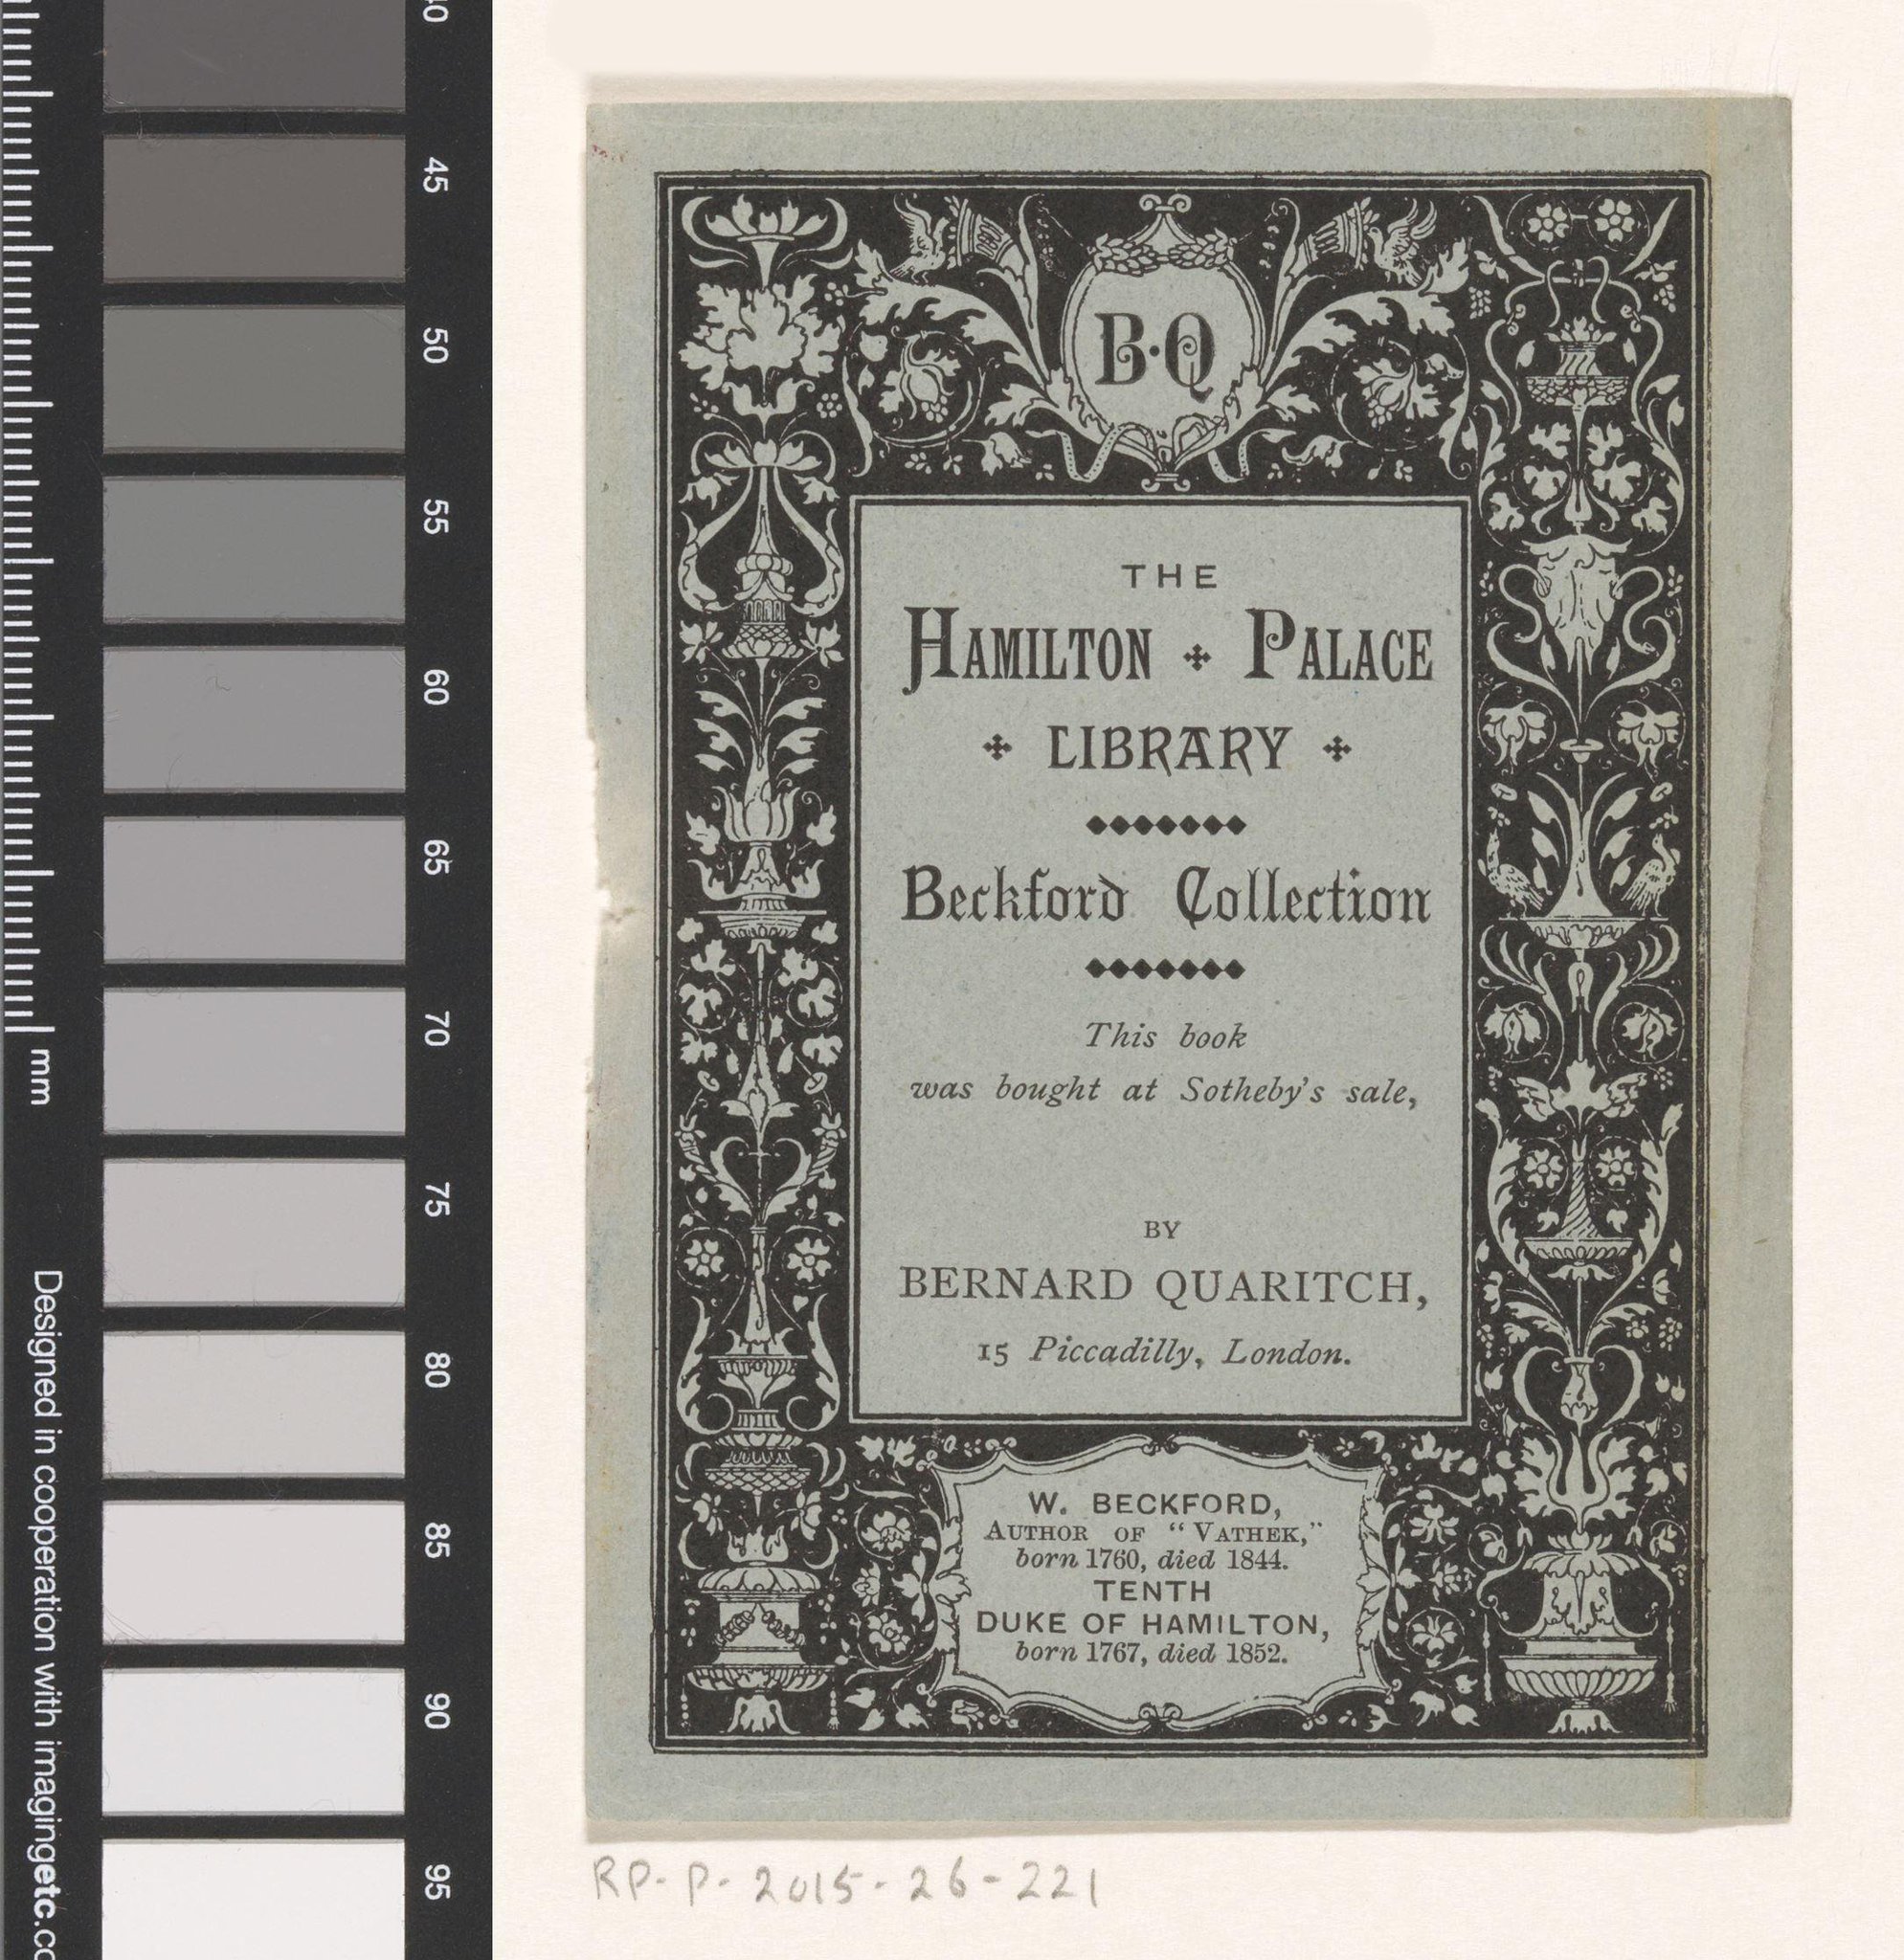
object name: print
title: Ex libris van Bernard Quaritch, boekhandelaar te Londen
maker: Anonymous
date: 1882-1884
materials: paper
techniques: letterpress printing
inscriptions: collector's mark: Lugt 4780, collector's mark: Lugt 2228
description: Dit ex-libris werd door Quaritch gebruikt om aan te geven dat een boek afkomstig was uit de Hamilton Palace Library - Beckford Collection, geveild door Sotheby's in 1882-1884.